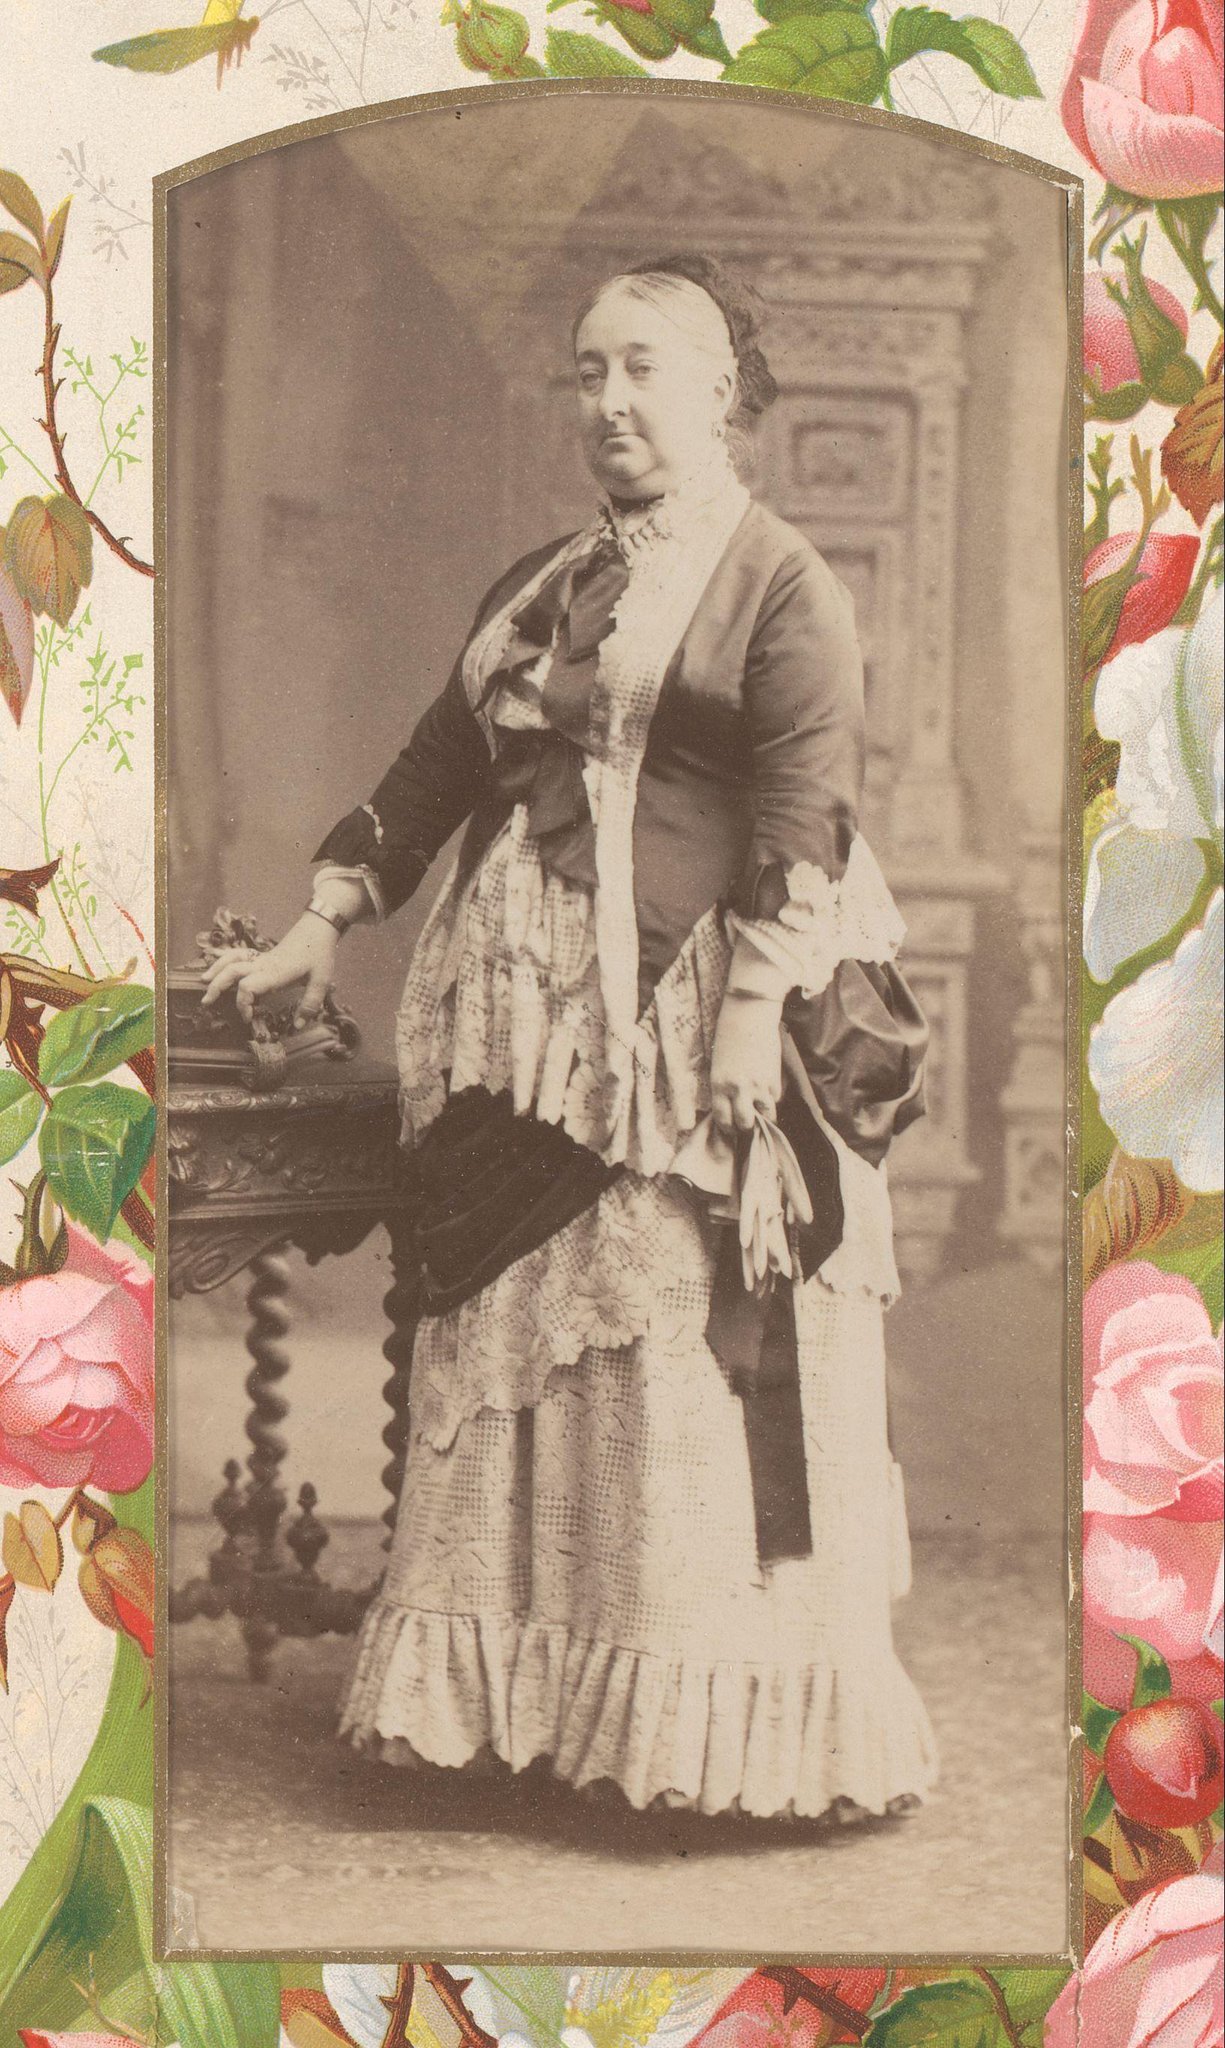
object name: album leaf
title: Portret van een staande vrouw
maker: jules alexandre joseph delzor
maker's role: fotograaf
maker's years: 1841-1902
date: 1880-1902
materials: cardboard, paper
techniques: albumen print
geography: epernay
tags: historical persons - bb - woman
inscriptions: inscription: ‘PHOTOGRAPHIE ARTISTIQUE/ ET AU CHARBON/ J. Delzor/ Rue Basse du Chemin de Fer, 19/ EPERNAY/ Les Clichés sont conservés.’